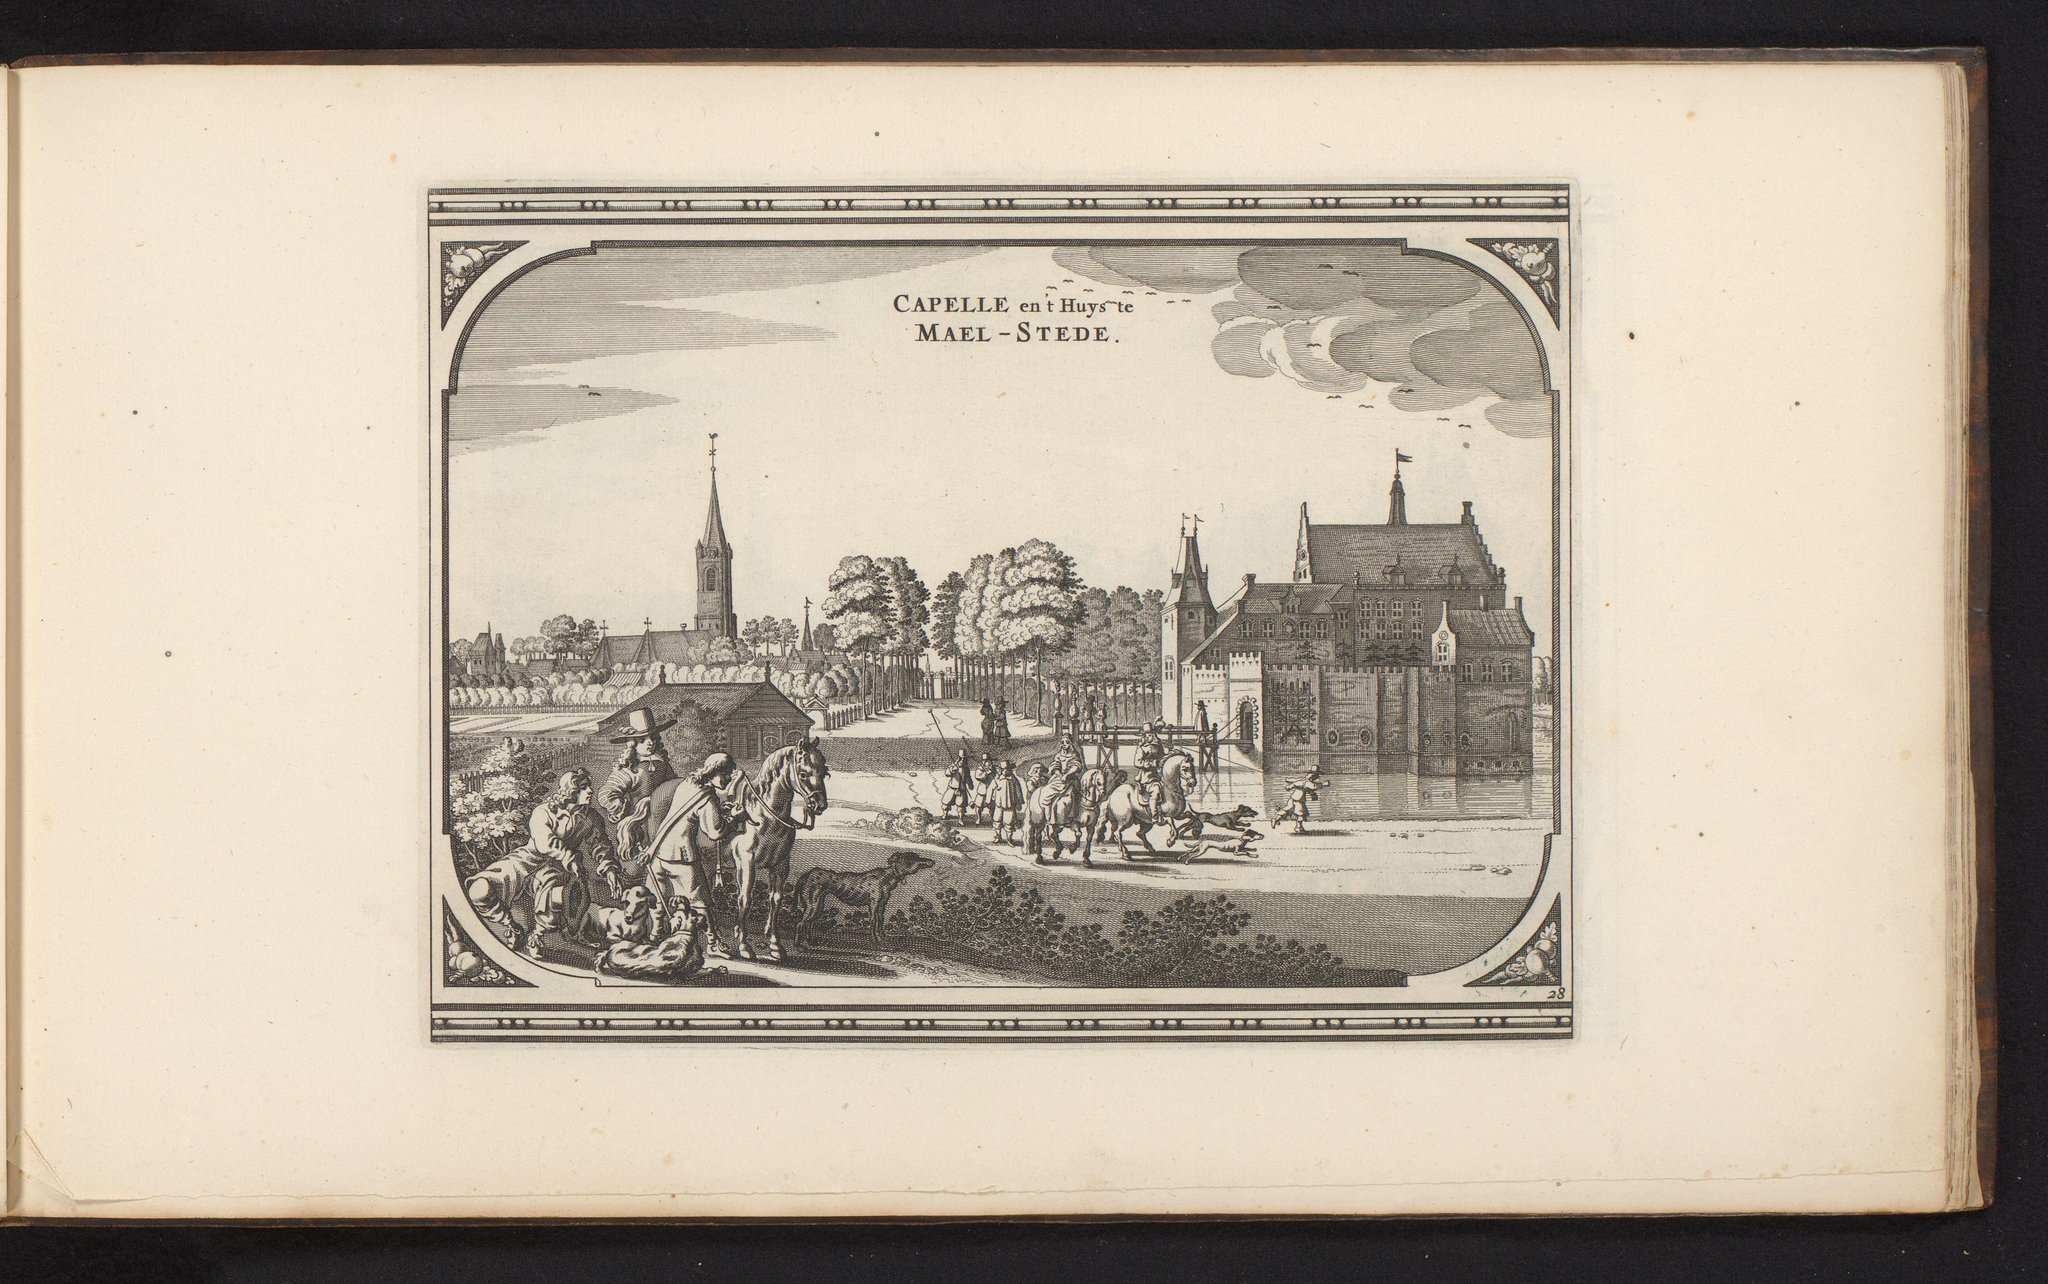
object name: album leaf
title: Capelle en 't Huys te Mael-Stede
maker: pieter hendricksz. schut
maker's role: print maker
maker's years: 1618-1660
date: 1662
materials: paper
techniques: etching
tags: city-view, and landscape with man-made constructions, castle, hunting, chase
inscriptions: collector's mark: Lugt 195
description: Gezicht op kasteel Maalstede en de kerk van Kapelle. Op een weg een jachtgezelschap. Op de voorgrond links wordt een paard klaargemaakt voor de jacht. De prent maakt deel uit van een album.